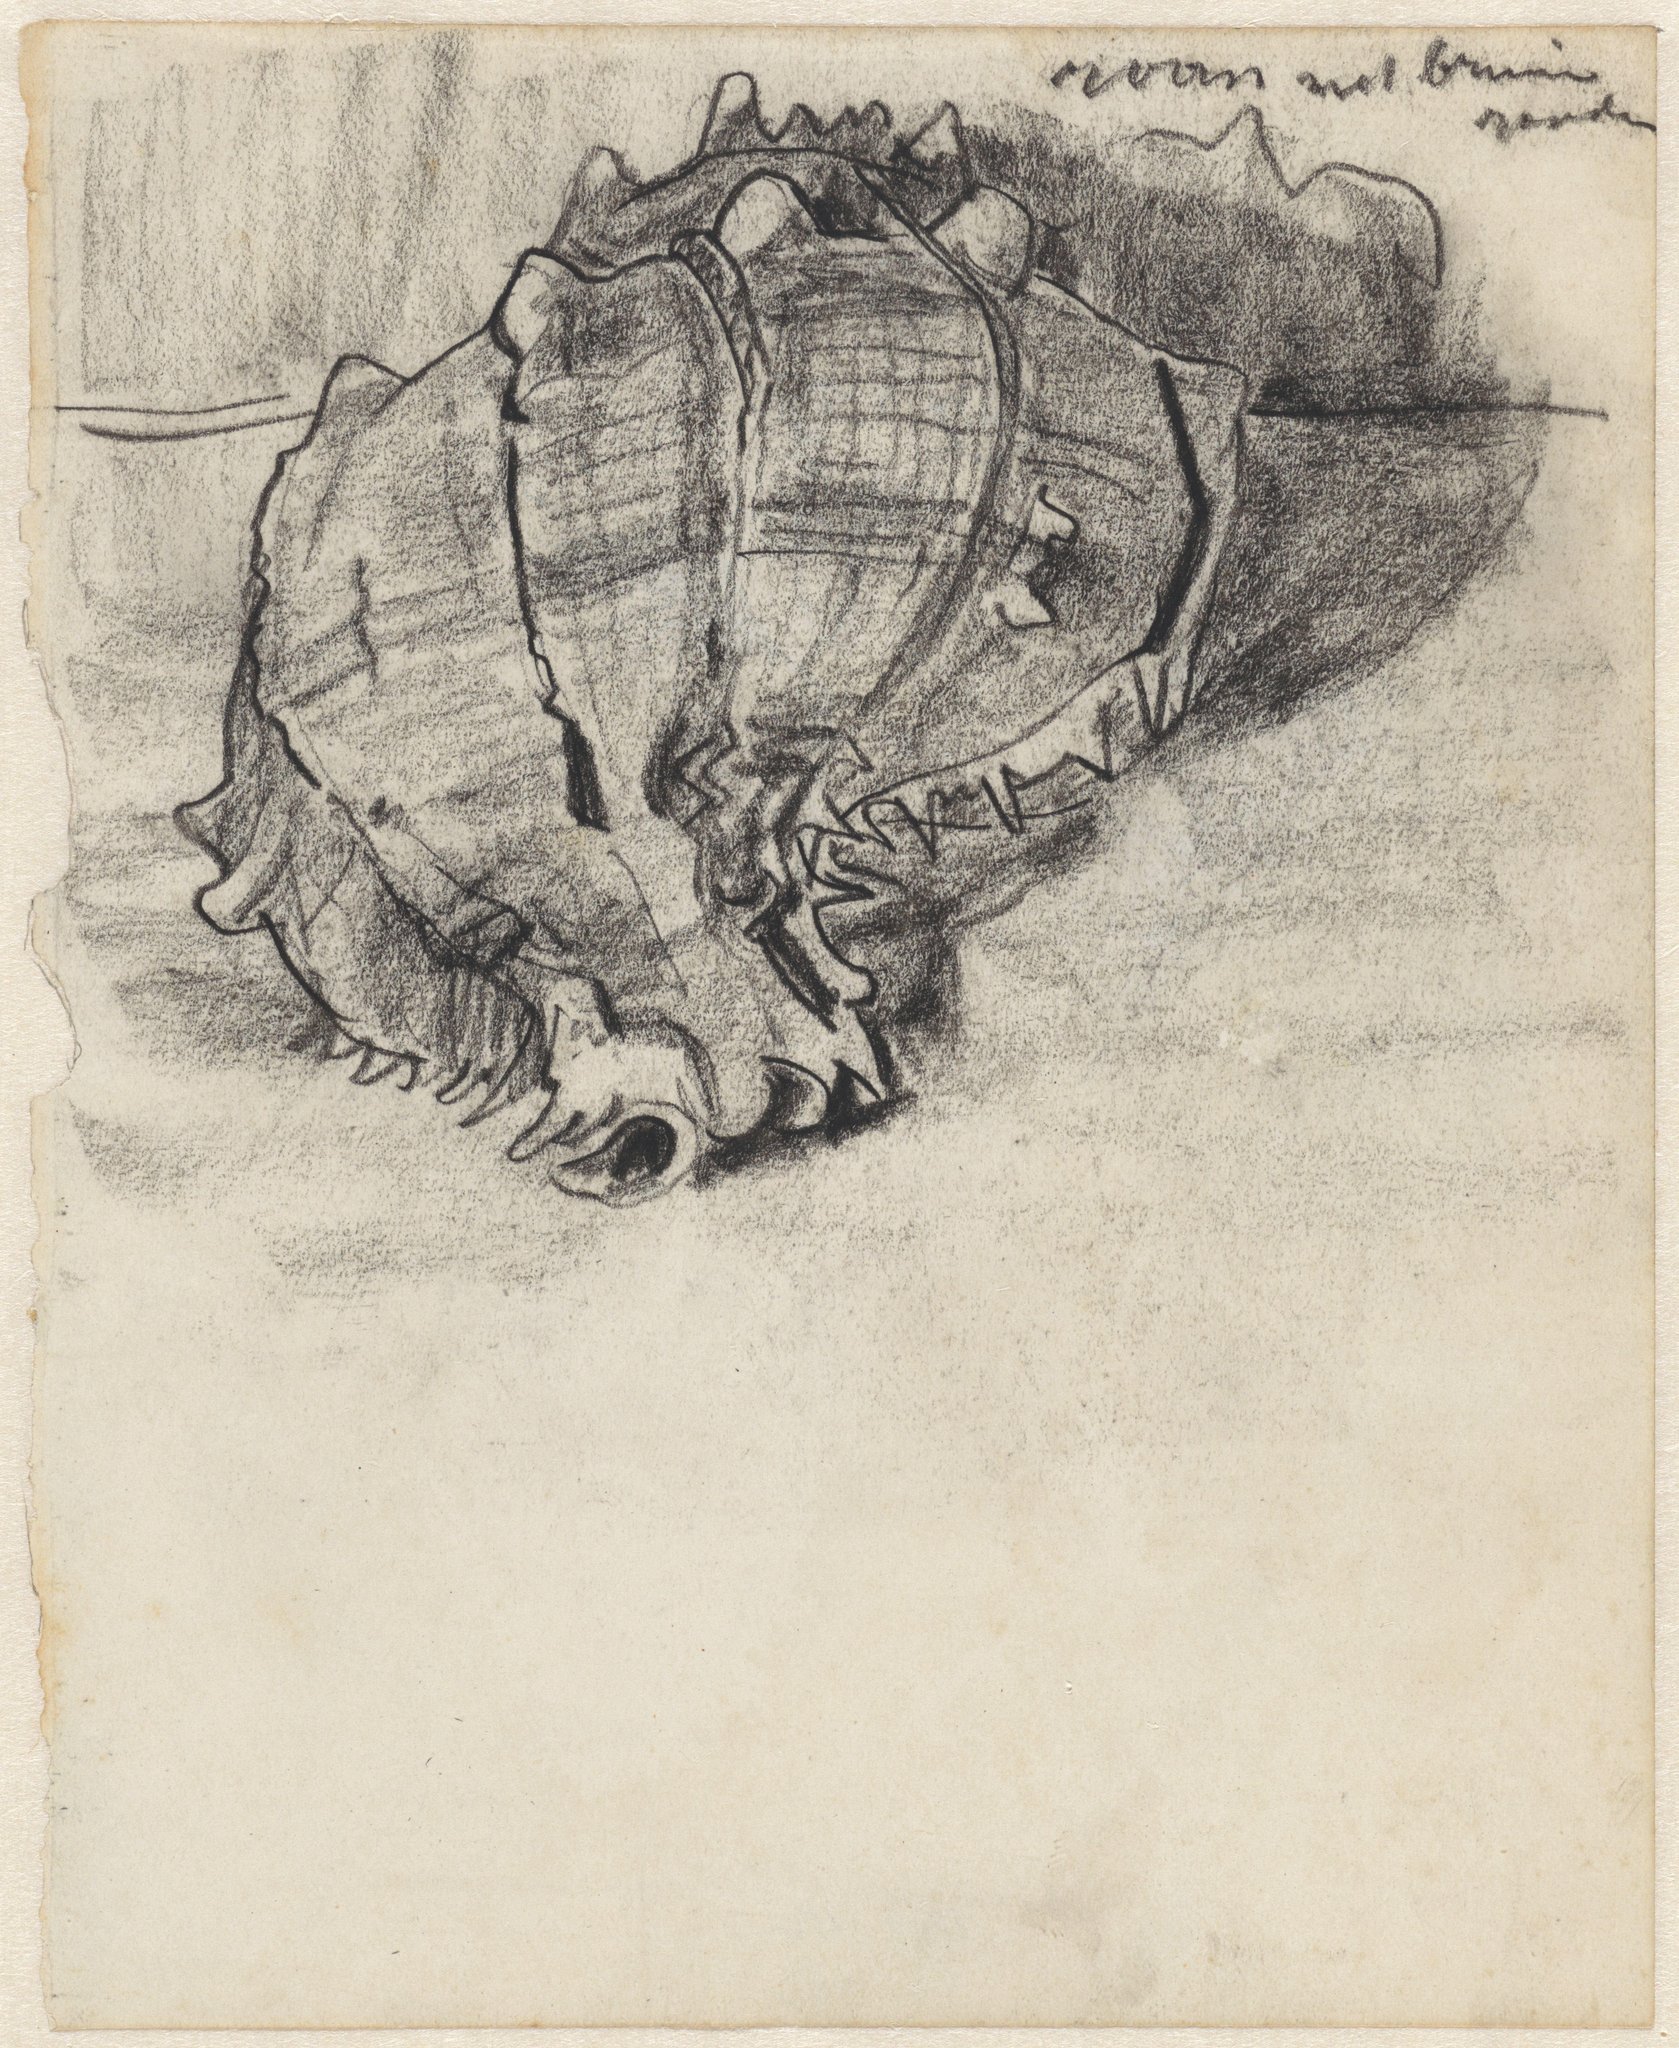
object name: drawing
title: Studie van een schelp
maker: theo nieuwenhuis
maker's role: designer, draughtsman, print maker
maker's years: 1866-1951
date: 1876-1951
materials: chalk, paper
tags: molluscs (+ shell, snail-shell etc.)